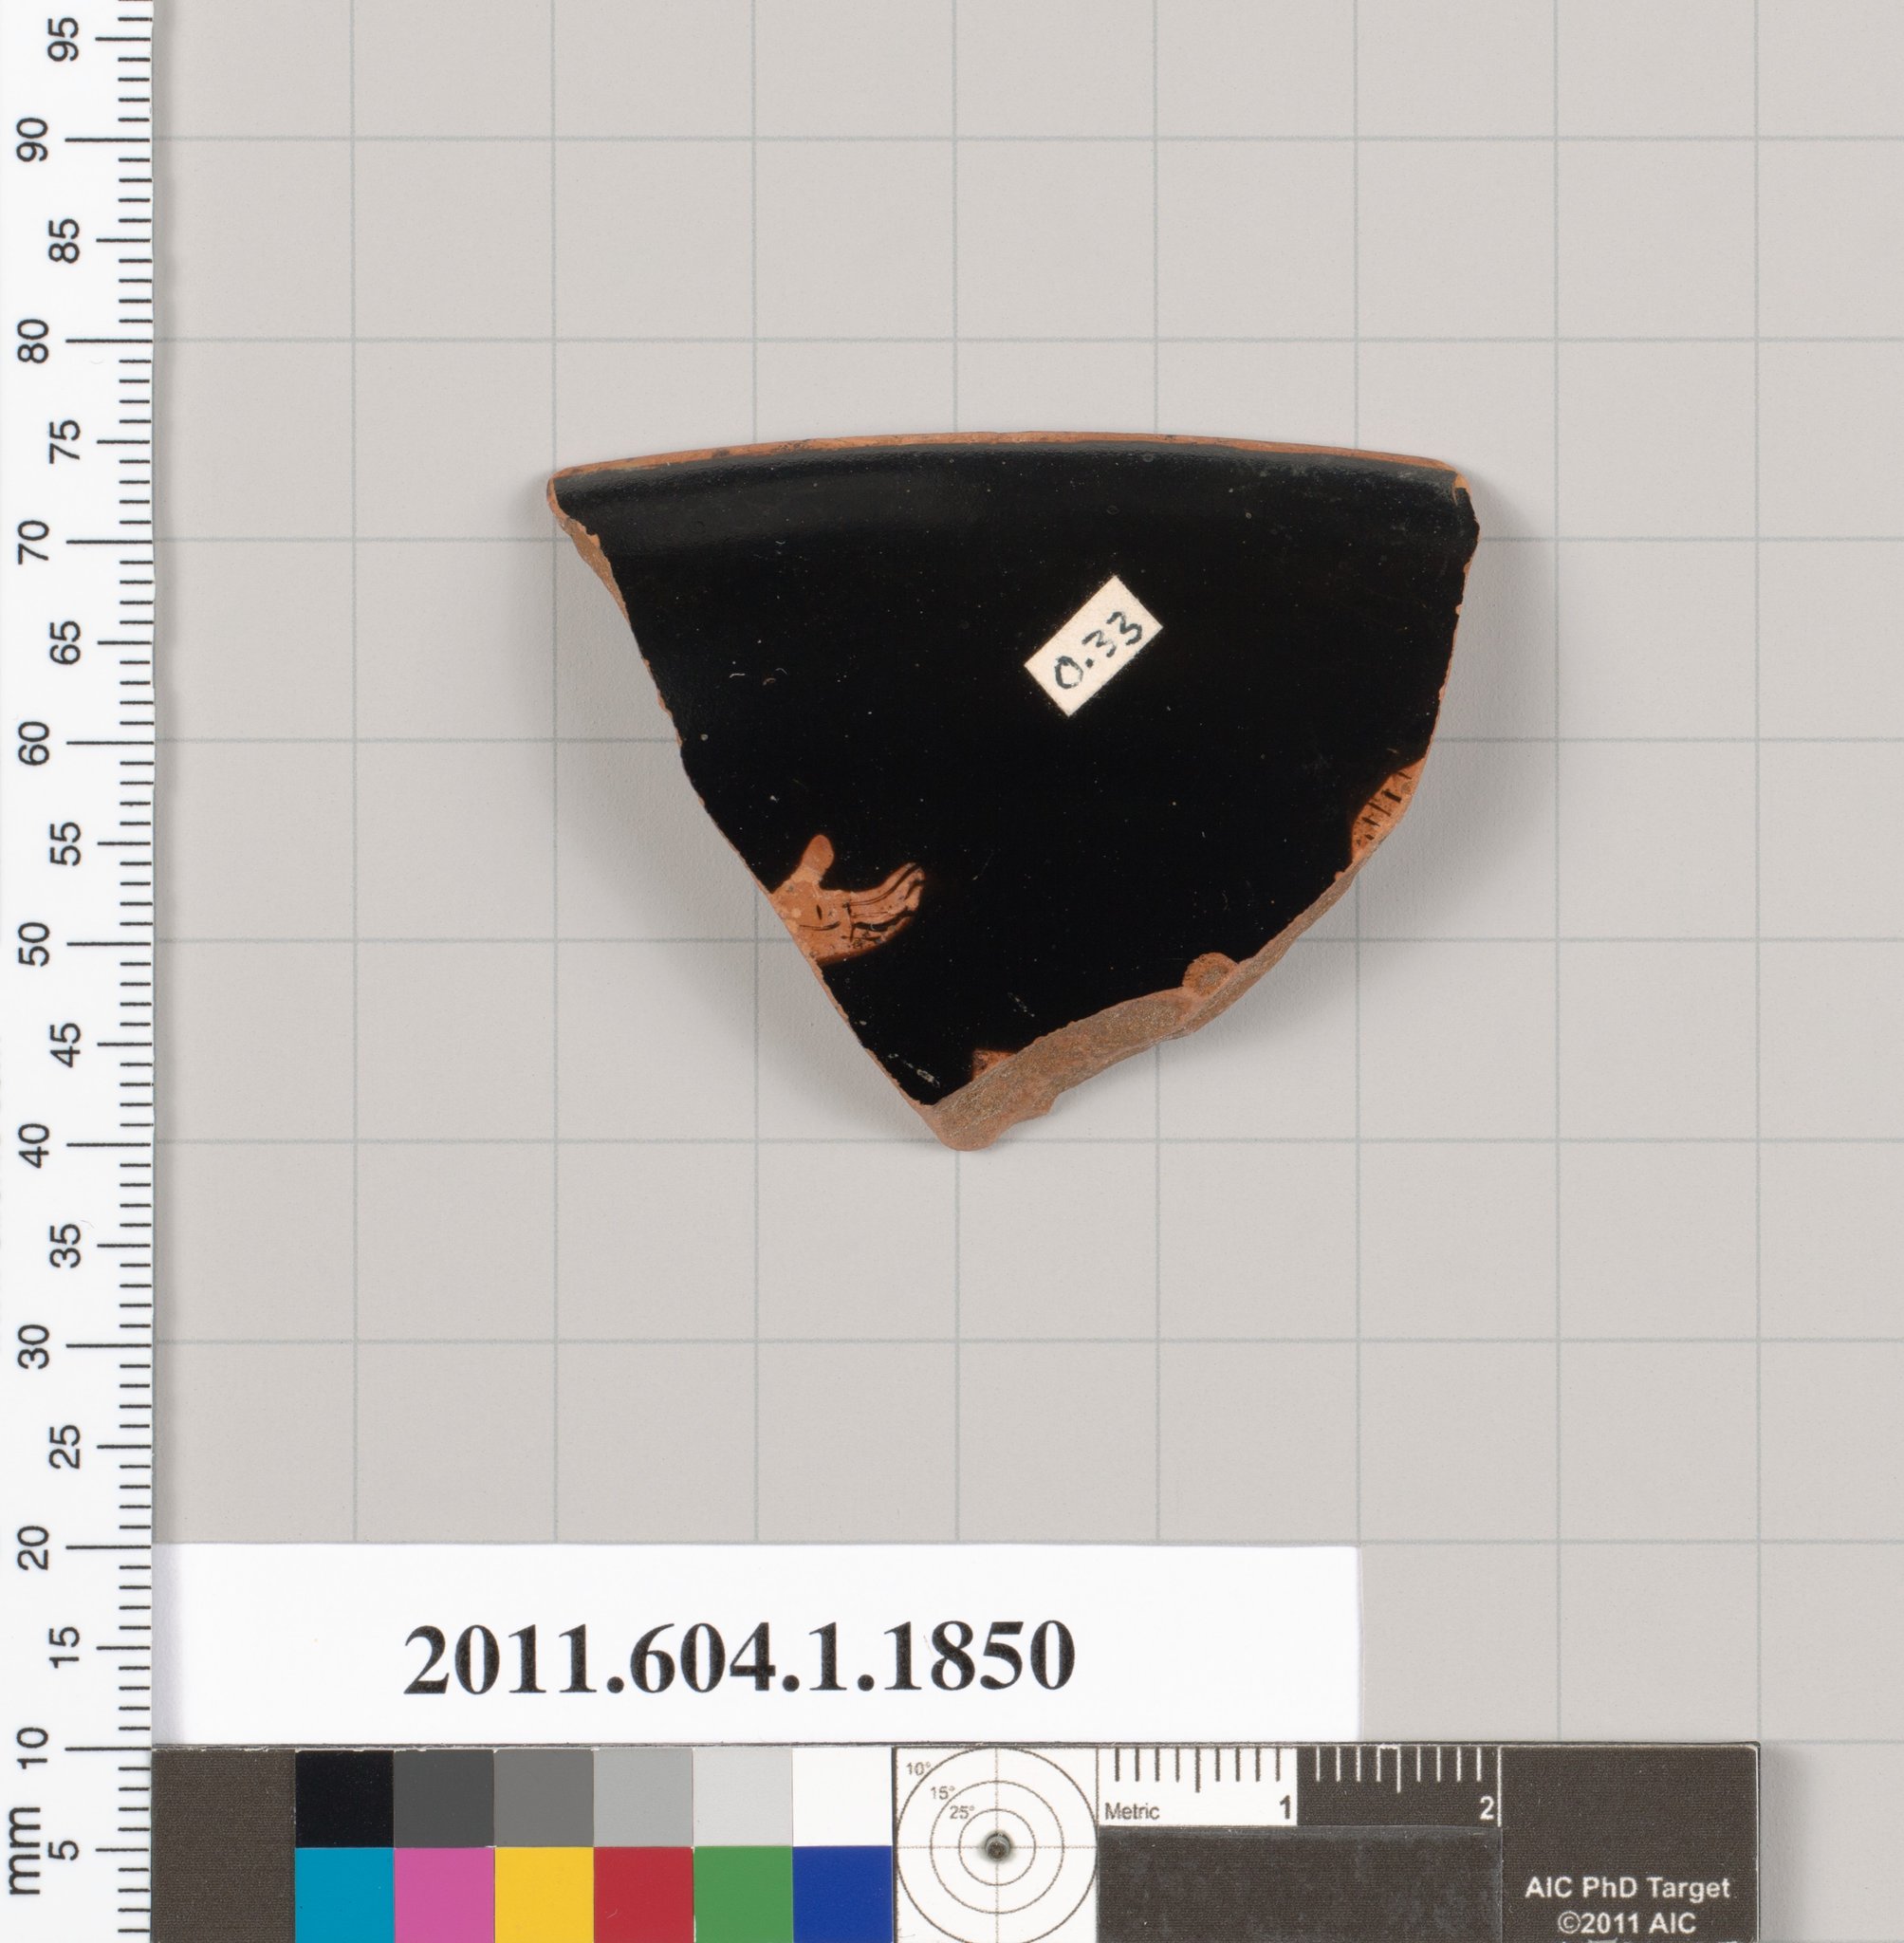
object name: kylix fragment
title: Terracotta rim fragment of a kylix (drinking cup)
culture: greek, attic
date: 470-450 BCE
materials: terracotta